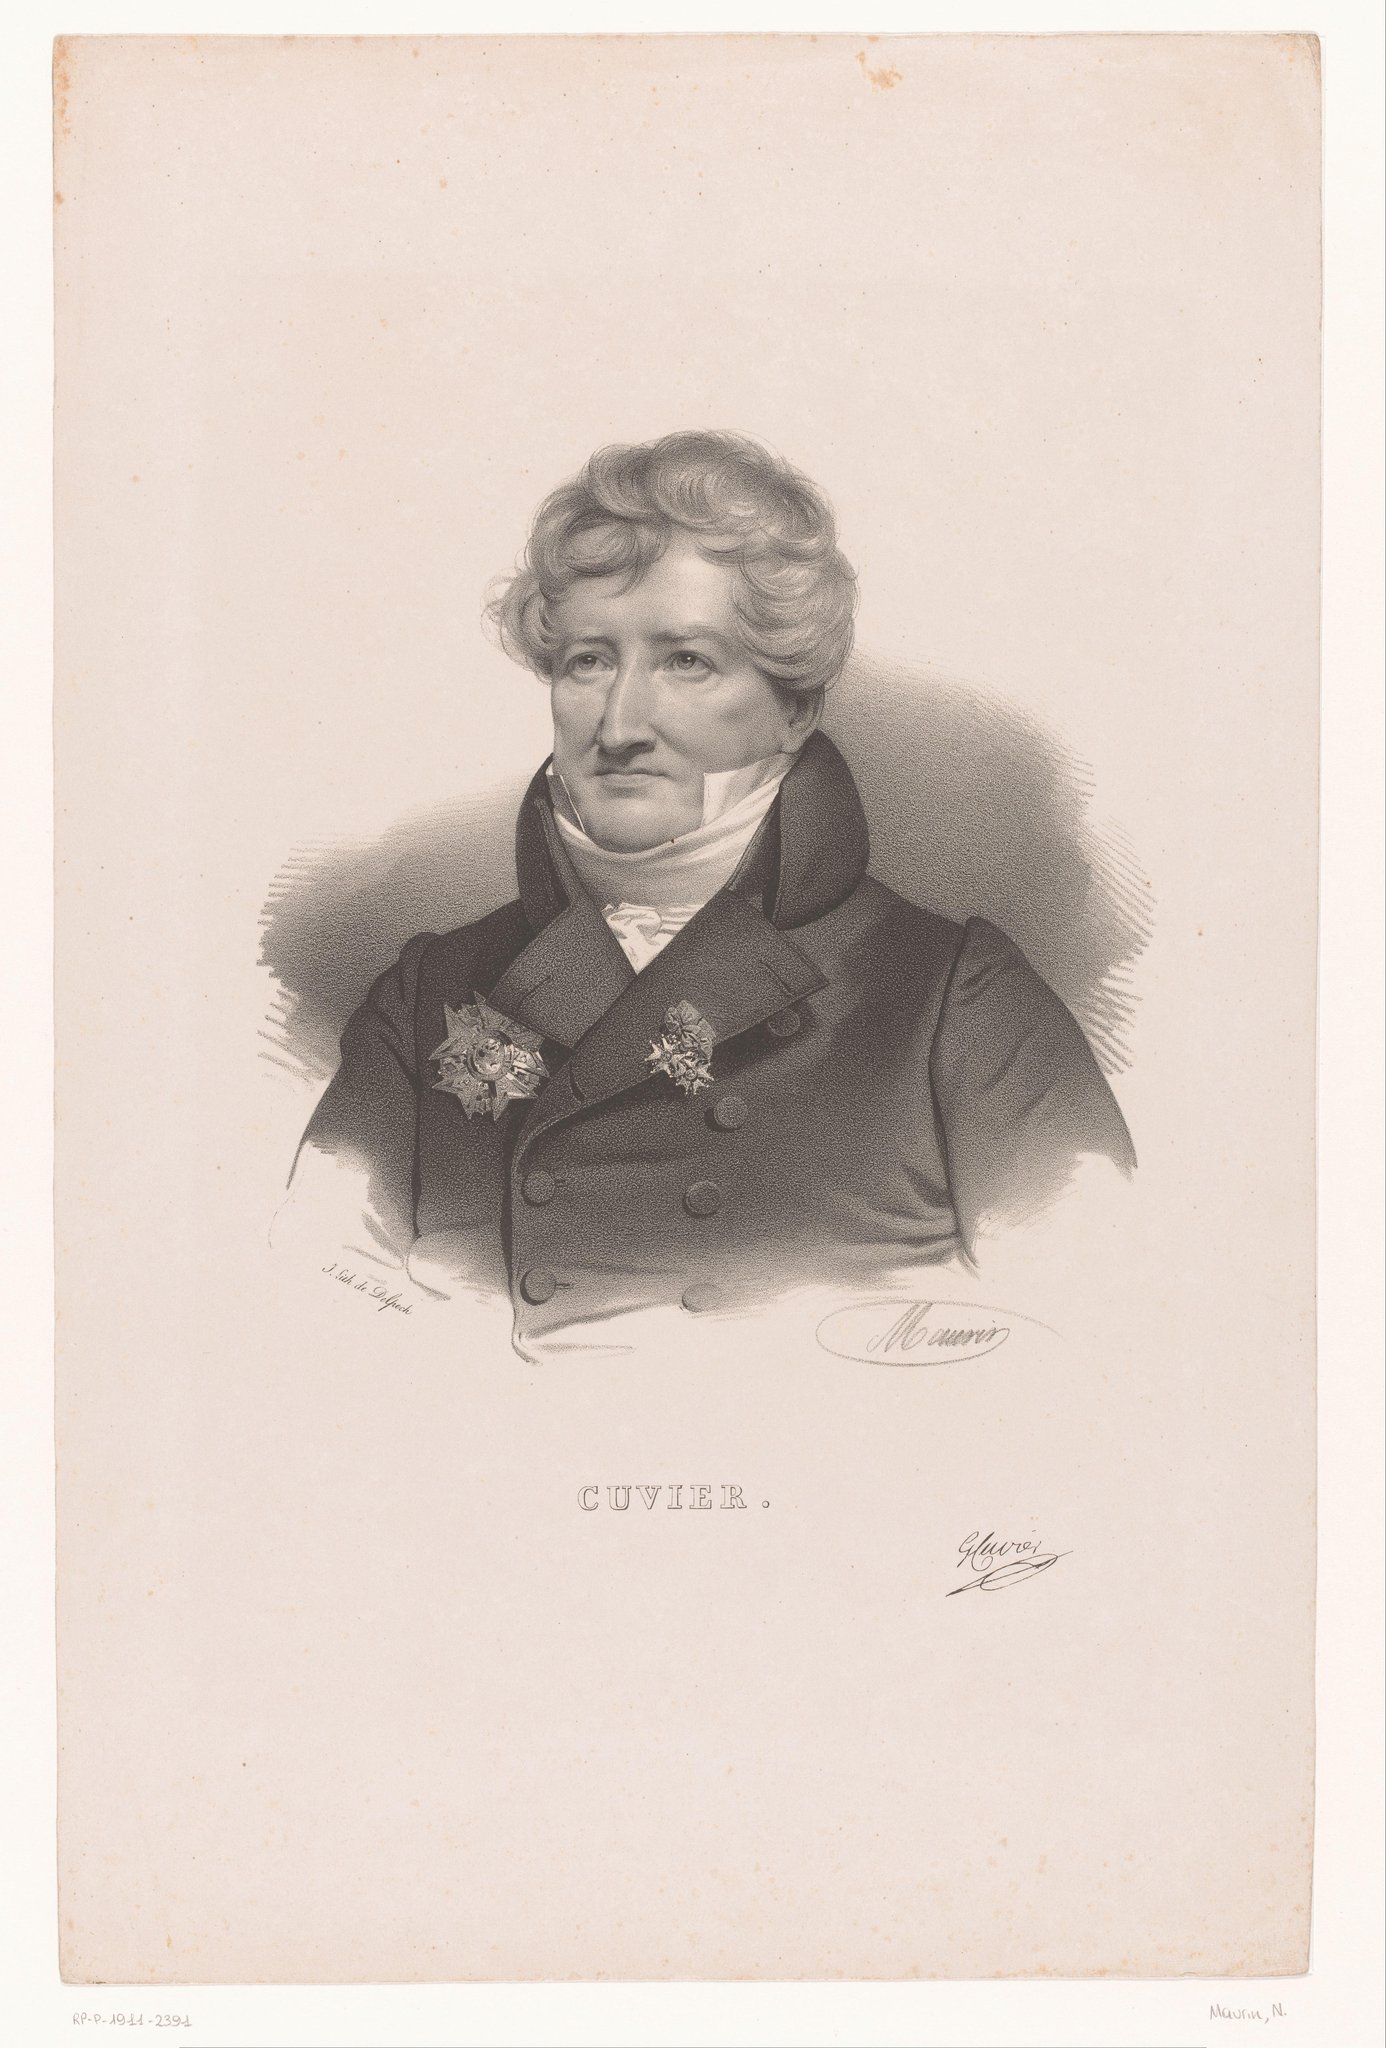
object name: print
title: Cuvier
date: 1825-1842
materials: paper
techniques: lithograph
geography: paris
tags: paris, scholar in his study, historical persons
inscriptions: collector's mark: Lugt 2228